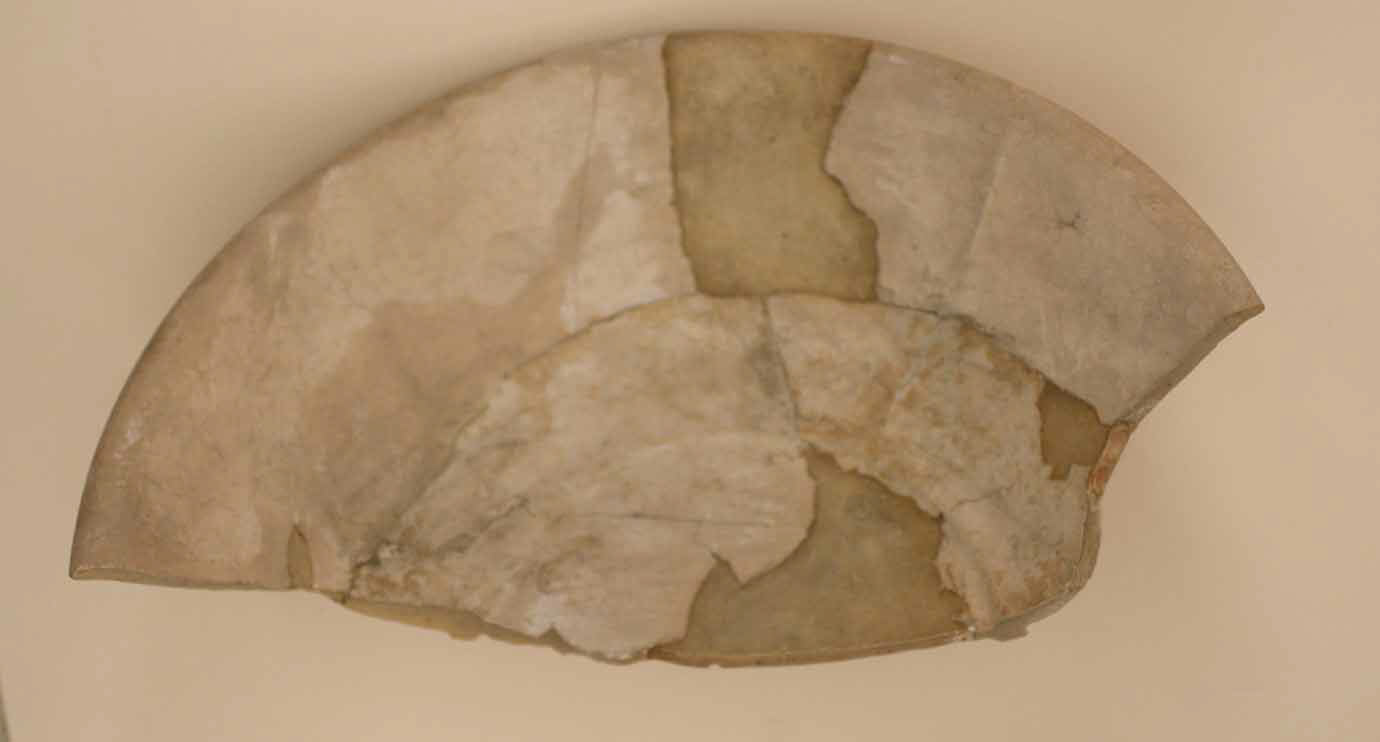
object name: fragment of a bowl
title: Fragment of a Bowl with White Glaze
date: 701-900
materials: earthenware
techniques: glazing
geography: iraq